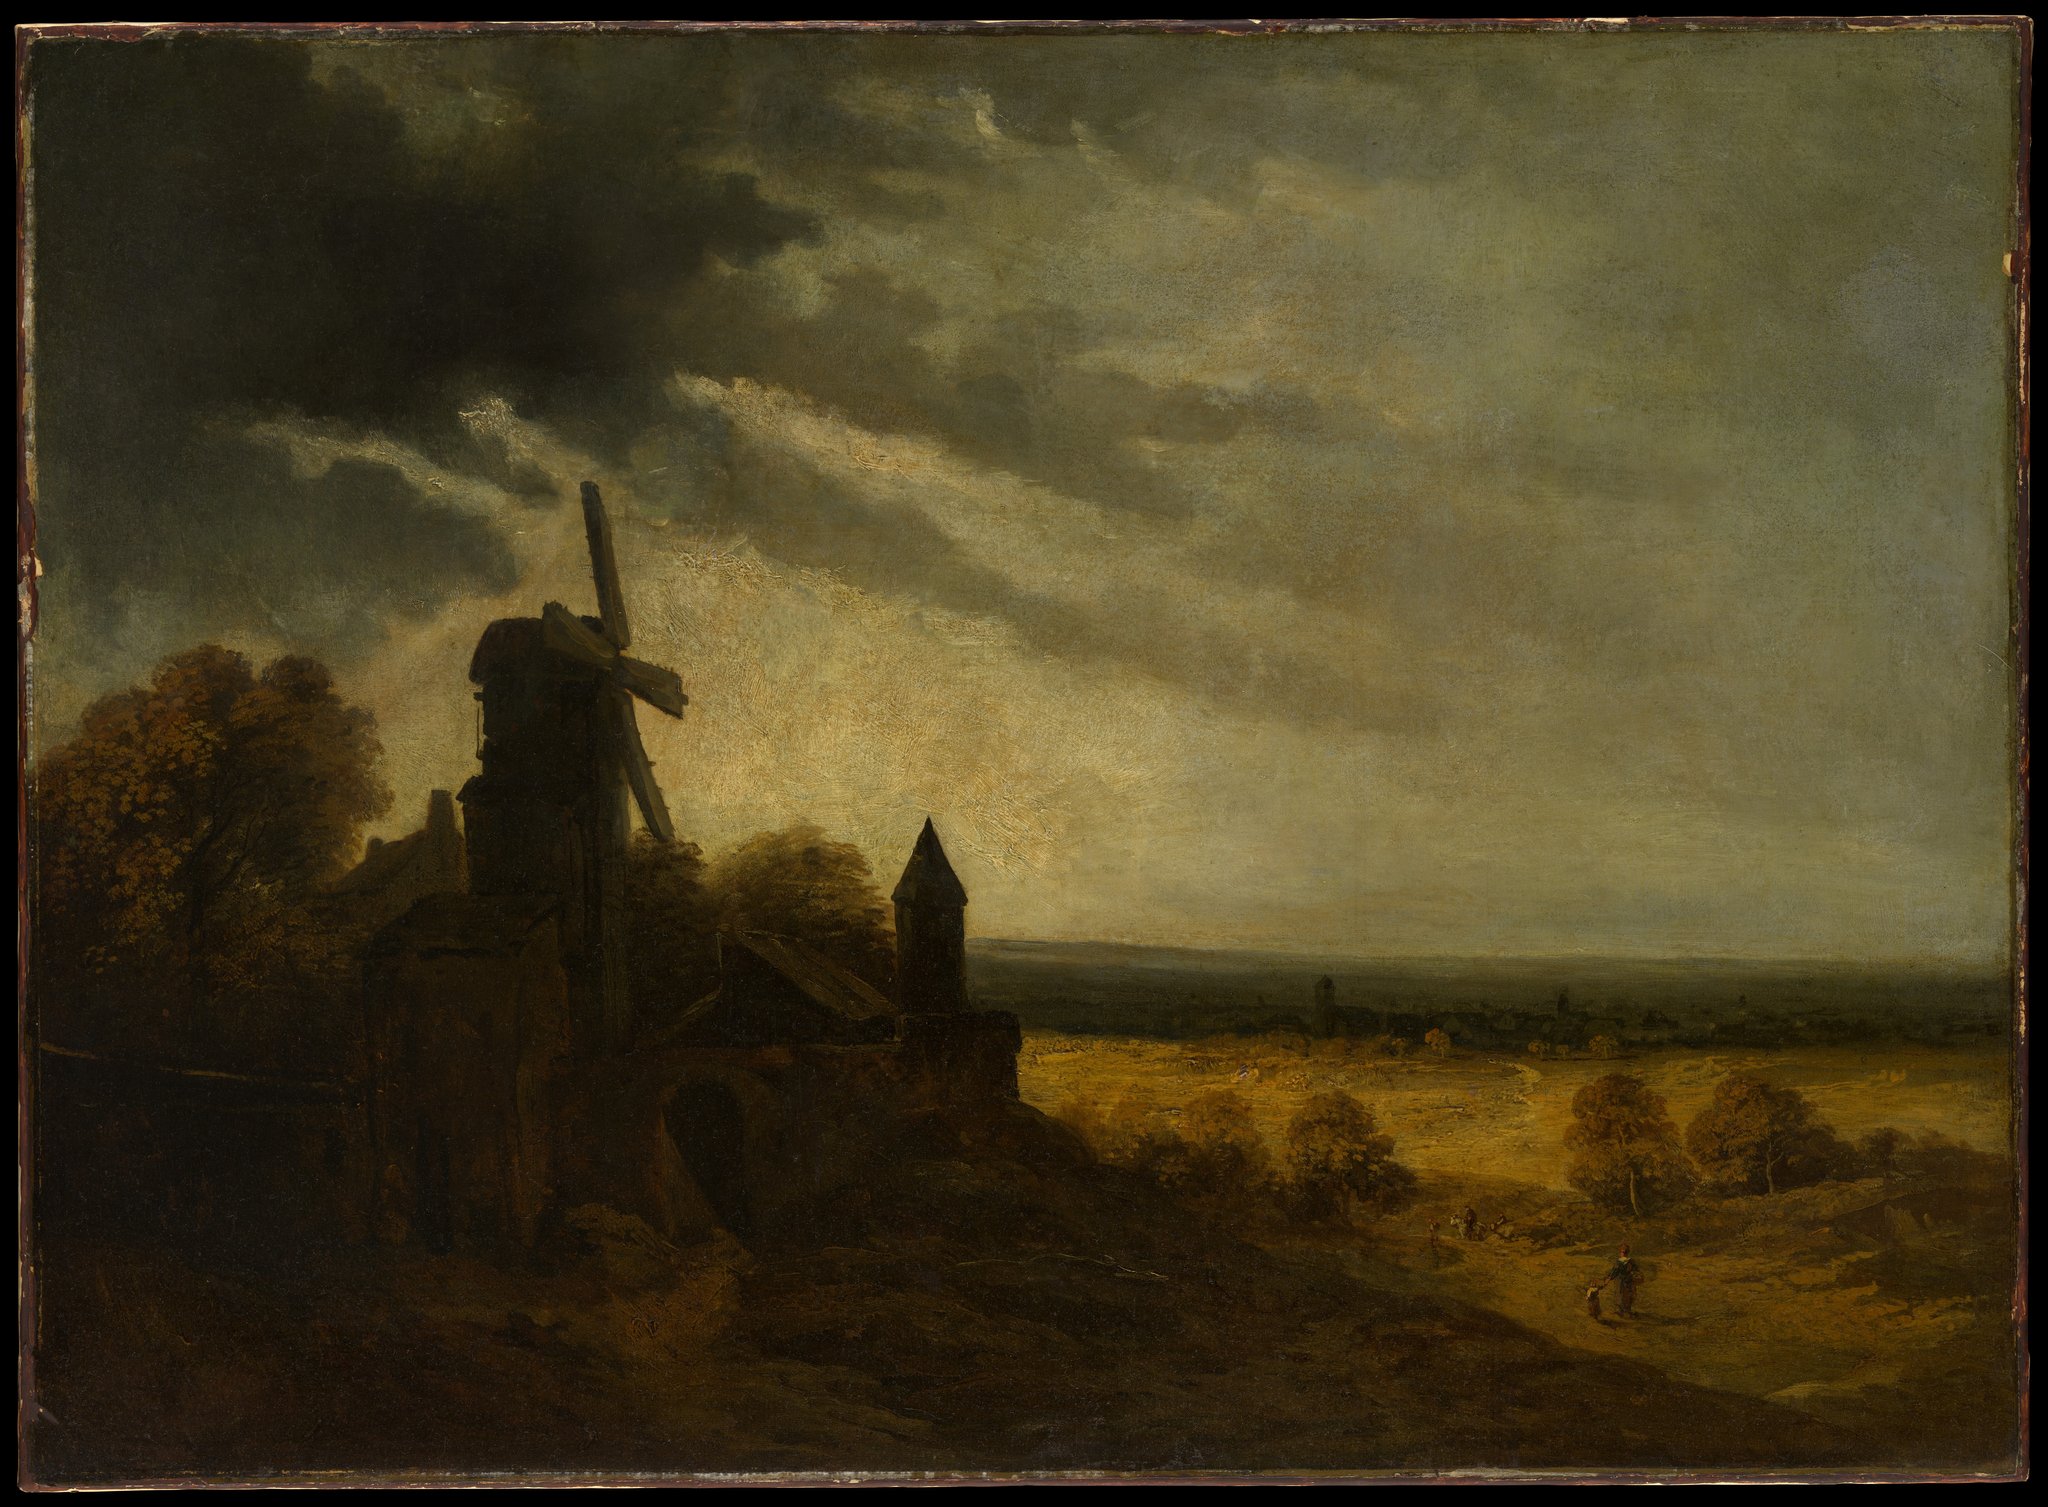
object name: painting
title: The Mill of Montmartre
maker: georges michel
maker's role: artist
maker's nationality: french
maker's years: 1763-1843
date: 1820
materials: canvas, oil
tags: windmills,landscapes,paris